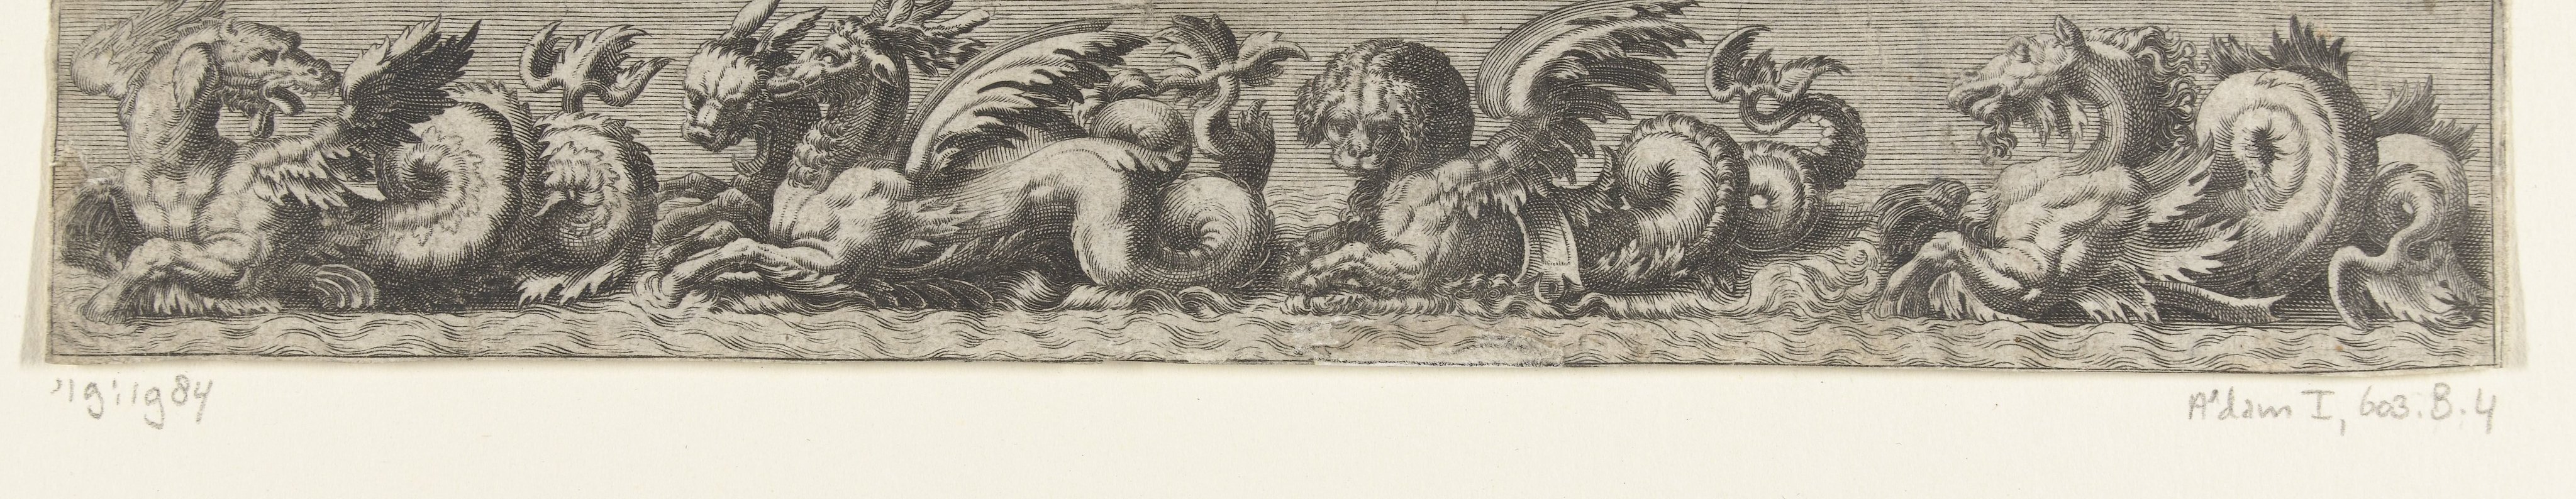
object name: print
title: Fries met aan de linkerkant een zeehond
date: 1580-1623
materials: paper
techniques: engraving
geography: germany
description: Tegenzijdige kopieën naar de volgende prenten: RP-P-1984-442, RP-P-1984-444, RP-P-1984-443 en RP-P-1984-437. Blad uit serie van 6.